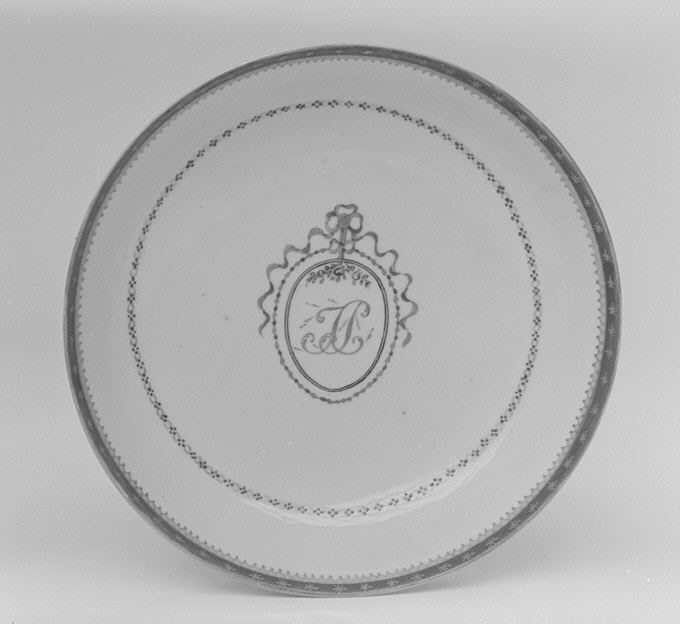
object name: saucer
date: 1785-1800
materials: hard paste porcelain